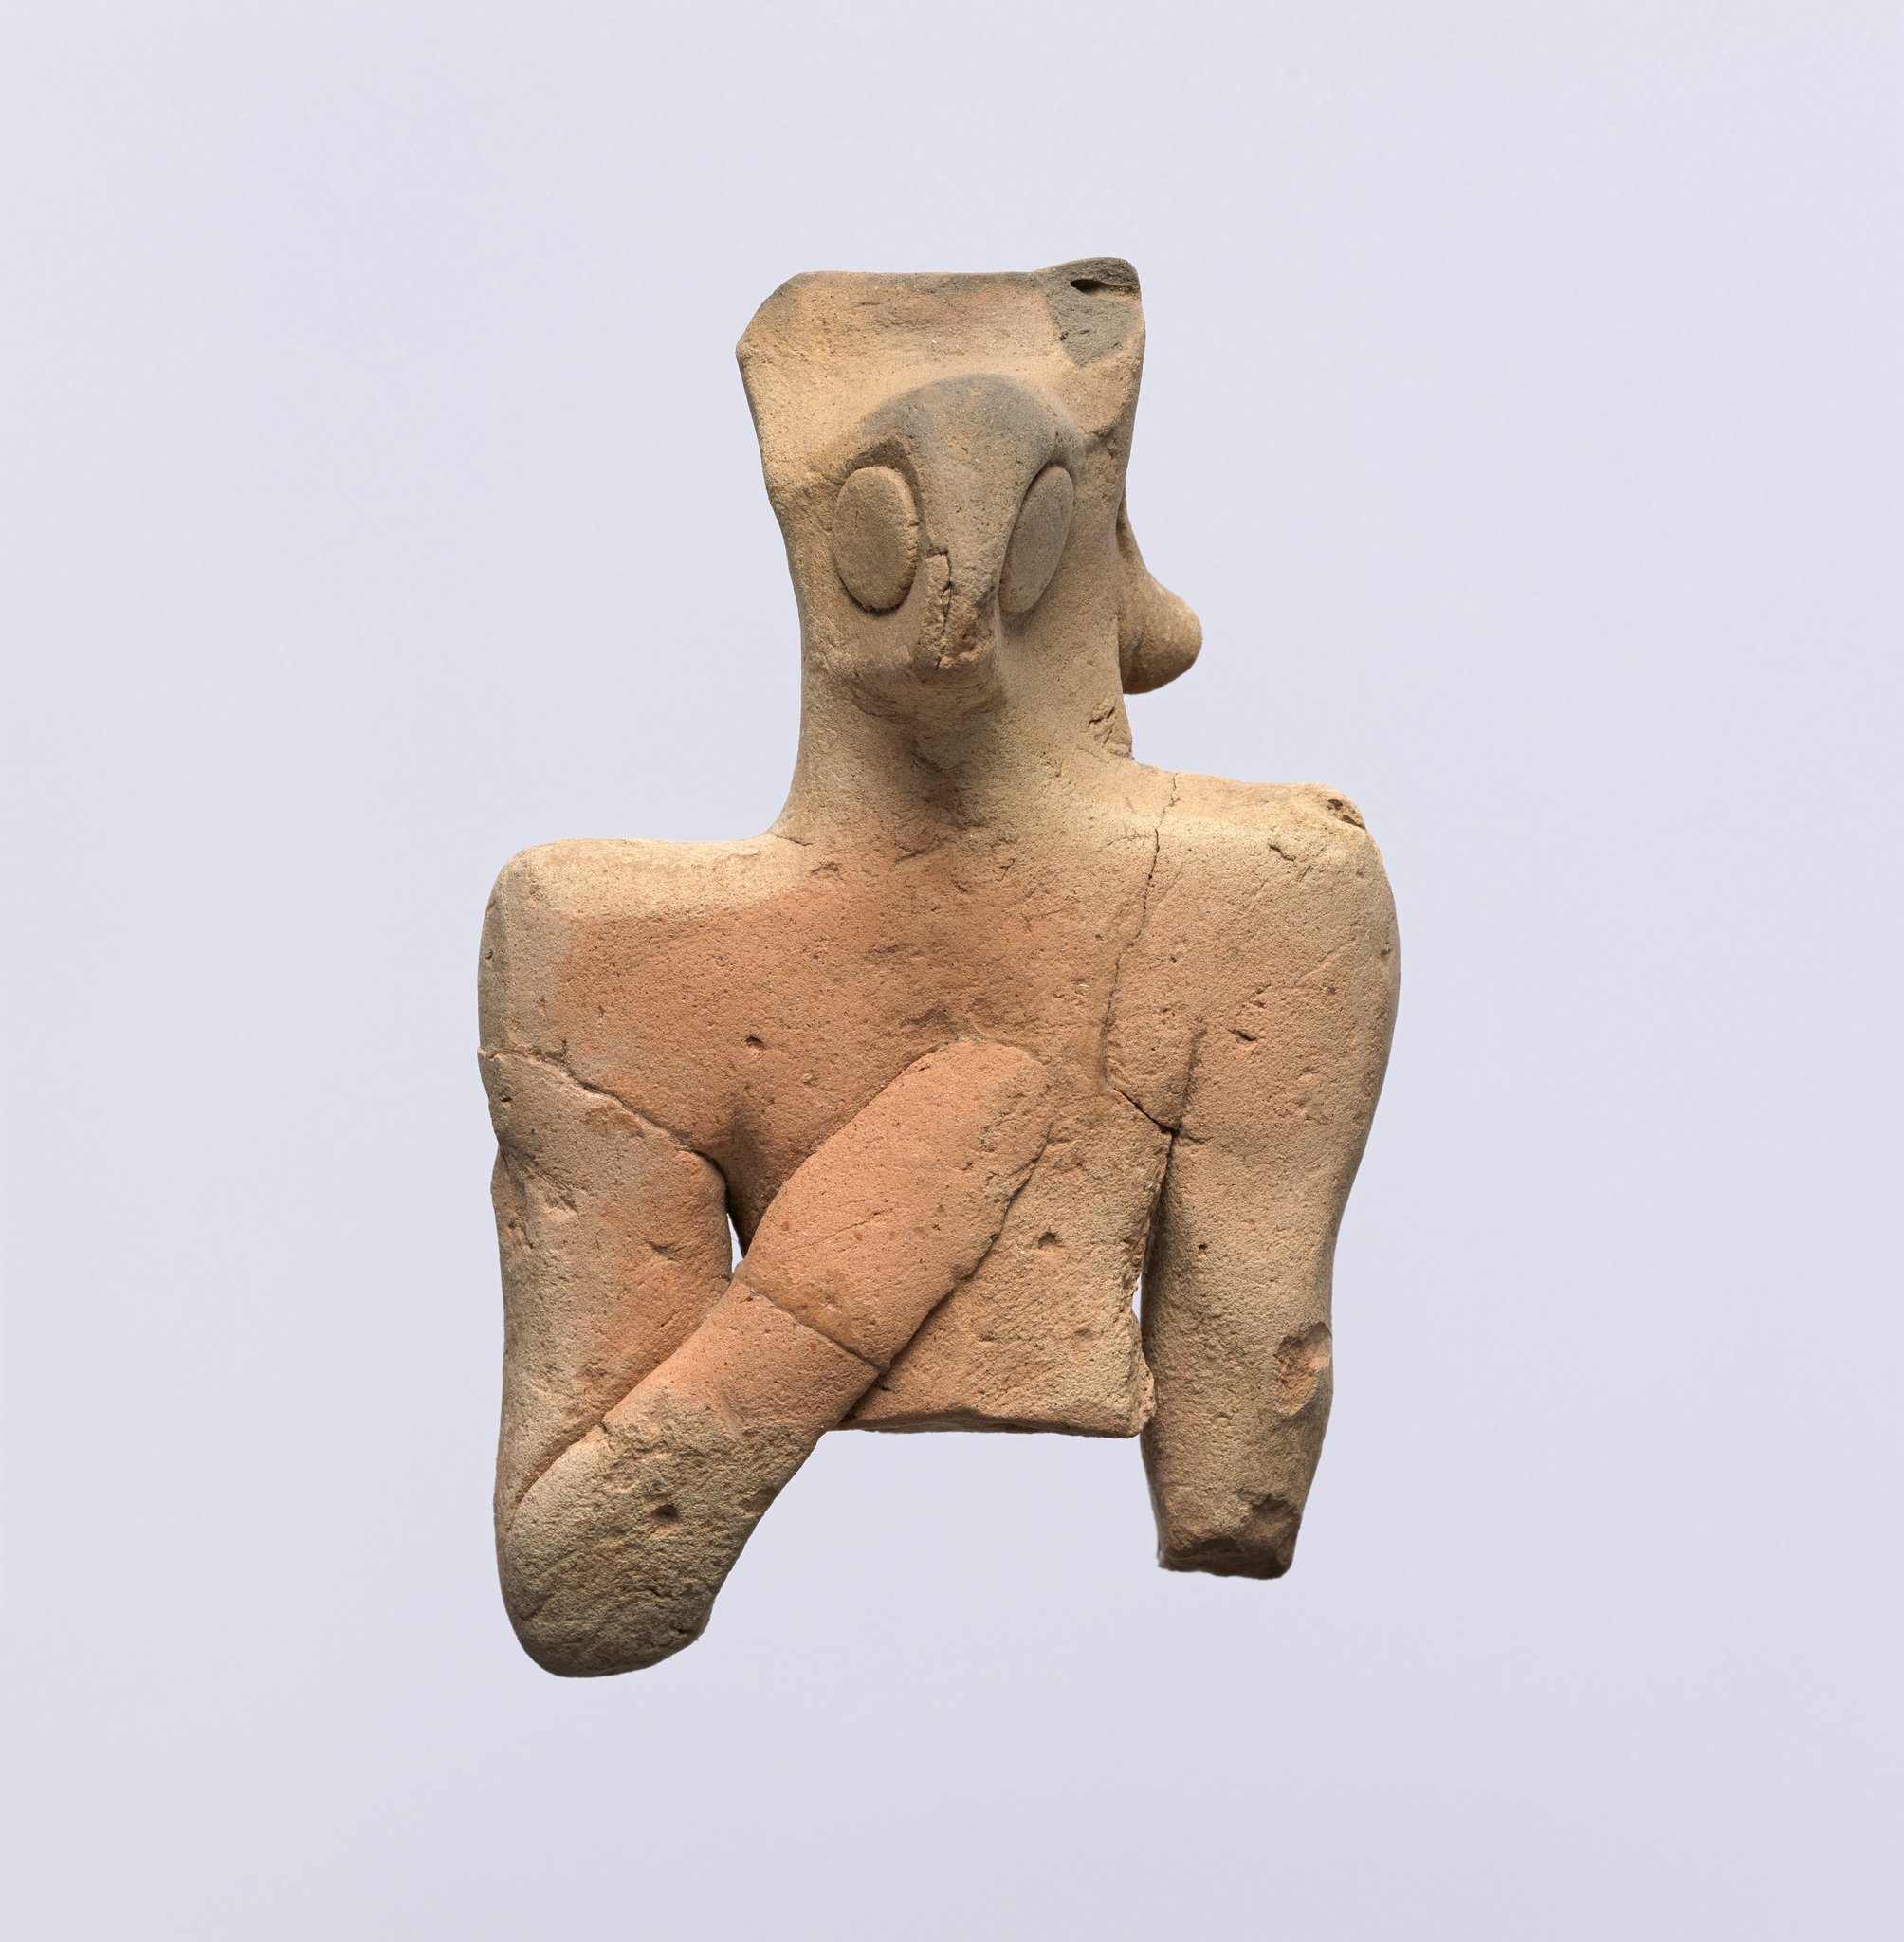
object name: sculpture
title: Figurine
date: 2350-2150 BCE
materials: ceramic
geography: mesopotamia